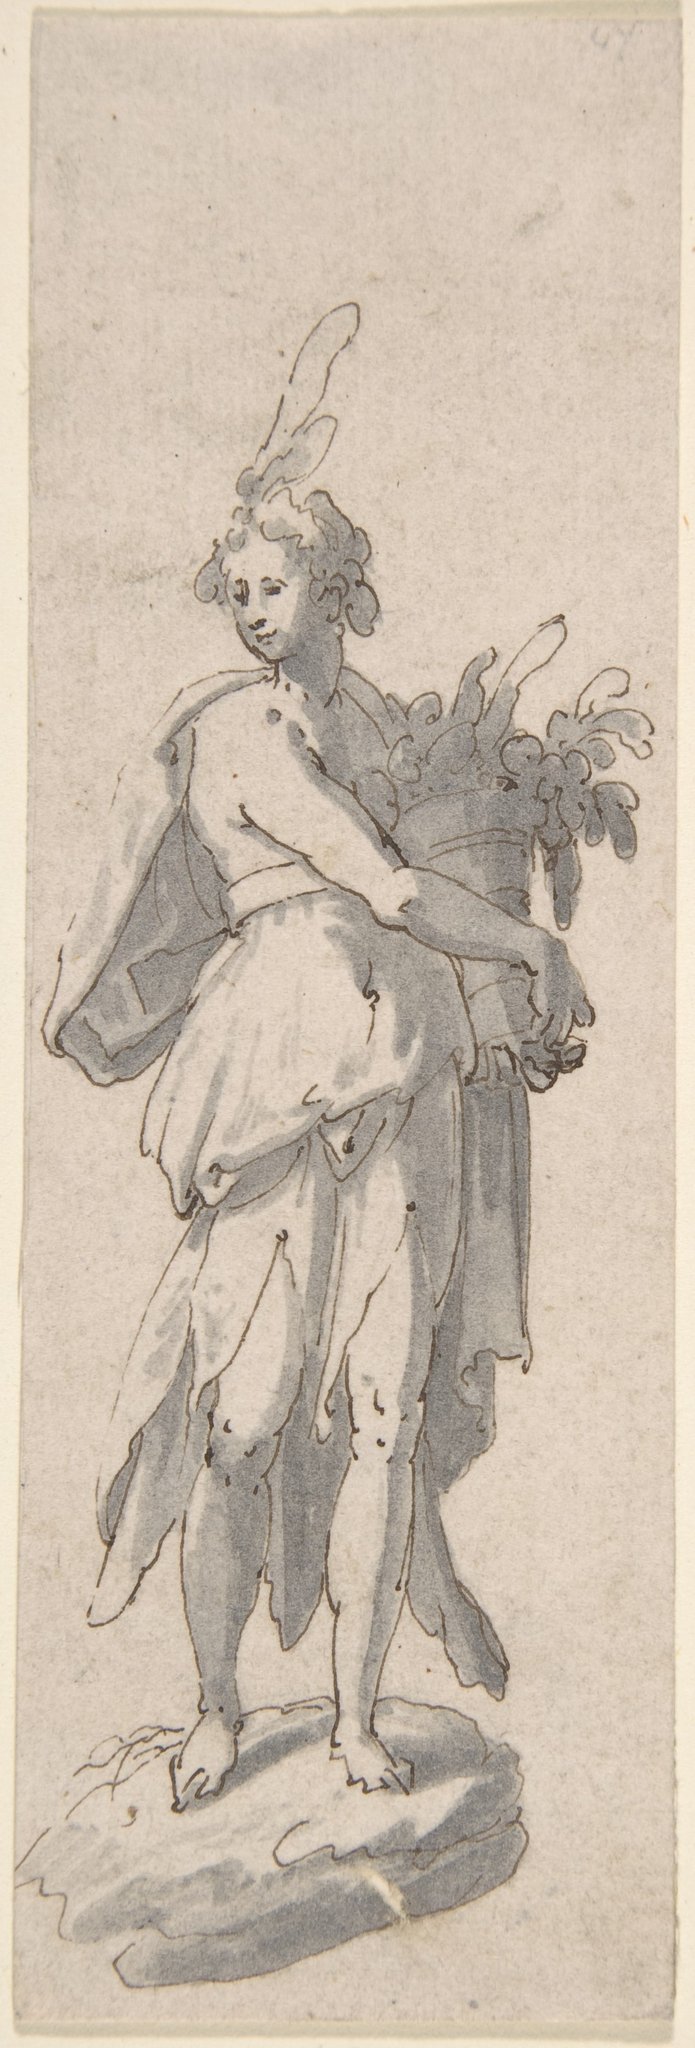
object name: drawing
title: Female Holding a Plant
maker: anonymous, italian, 17th century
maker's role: artist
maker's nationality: italian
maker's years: 1600-1700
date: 1601-1700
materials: ink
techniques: brush, pen, wash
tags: women,plants